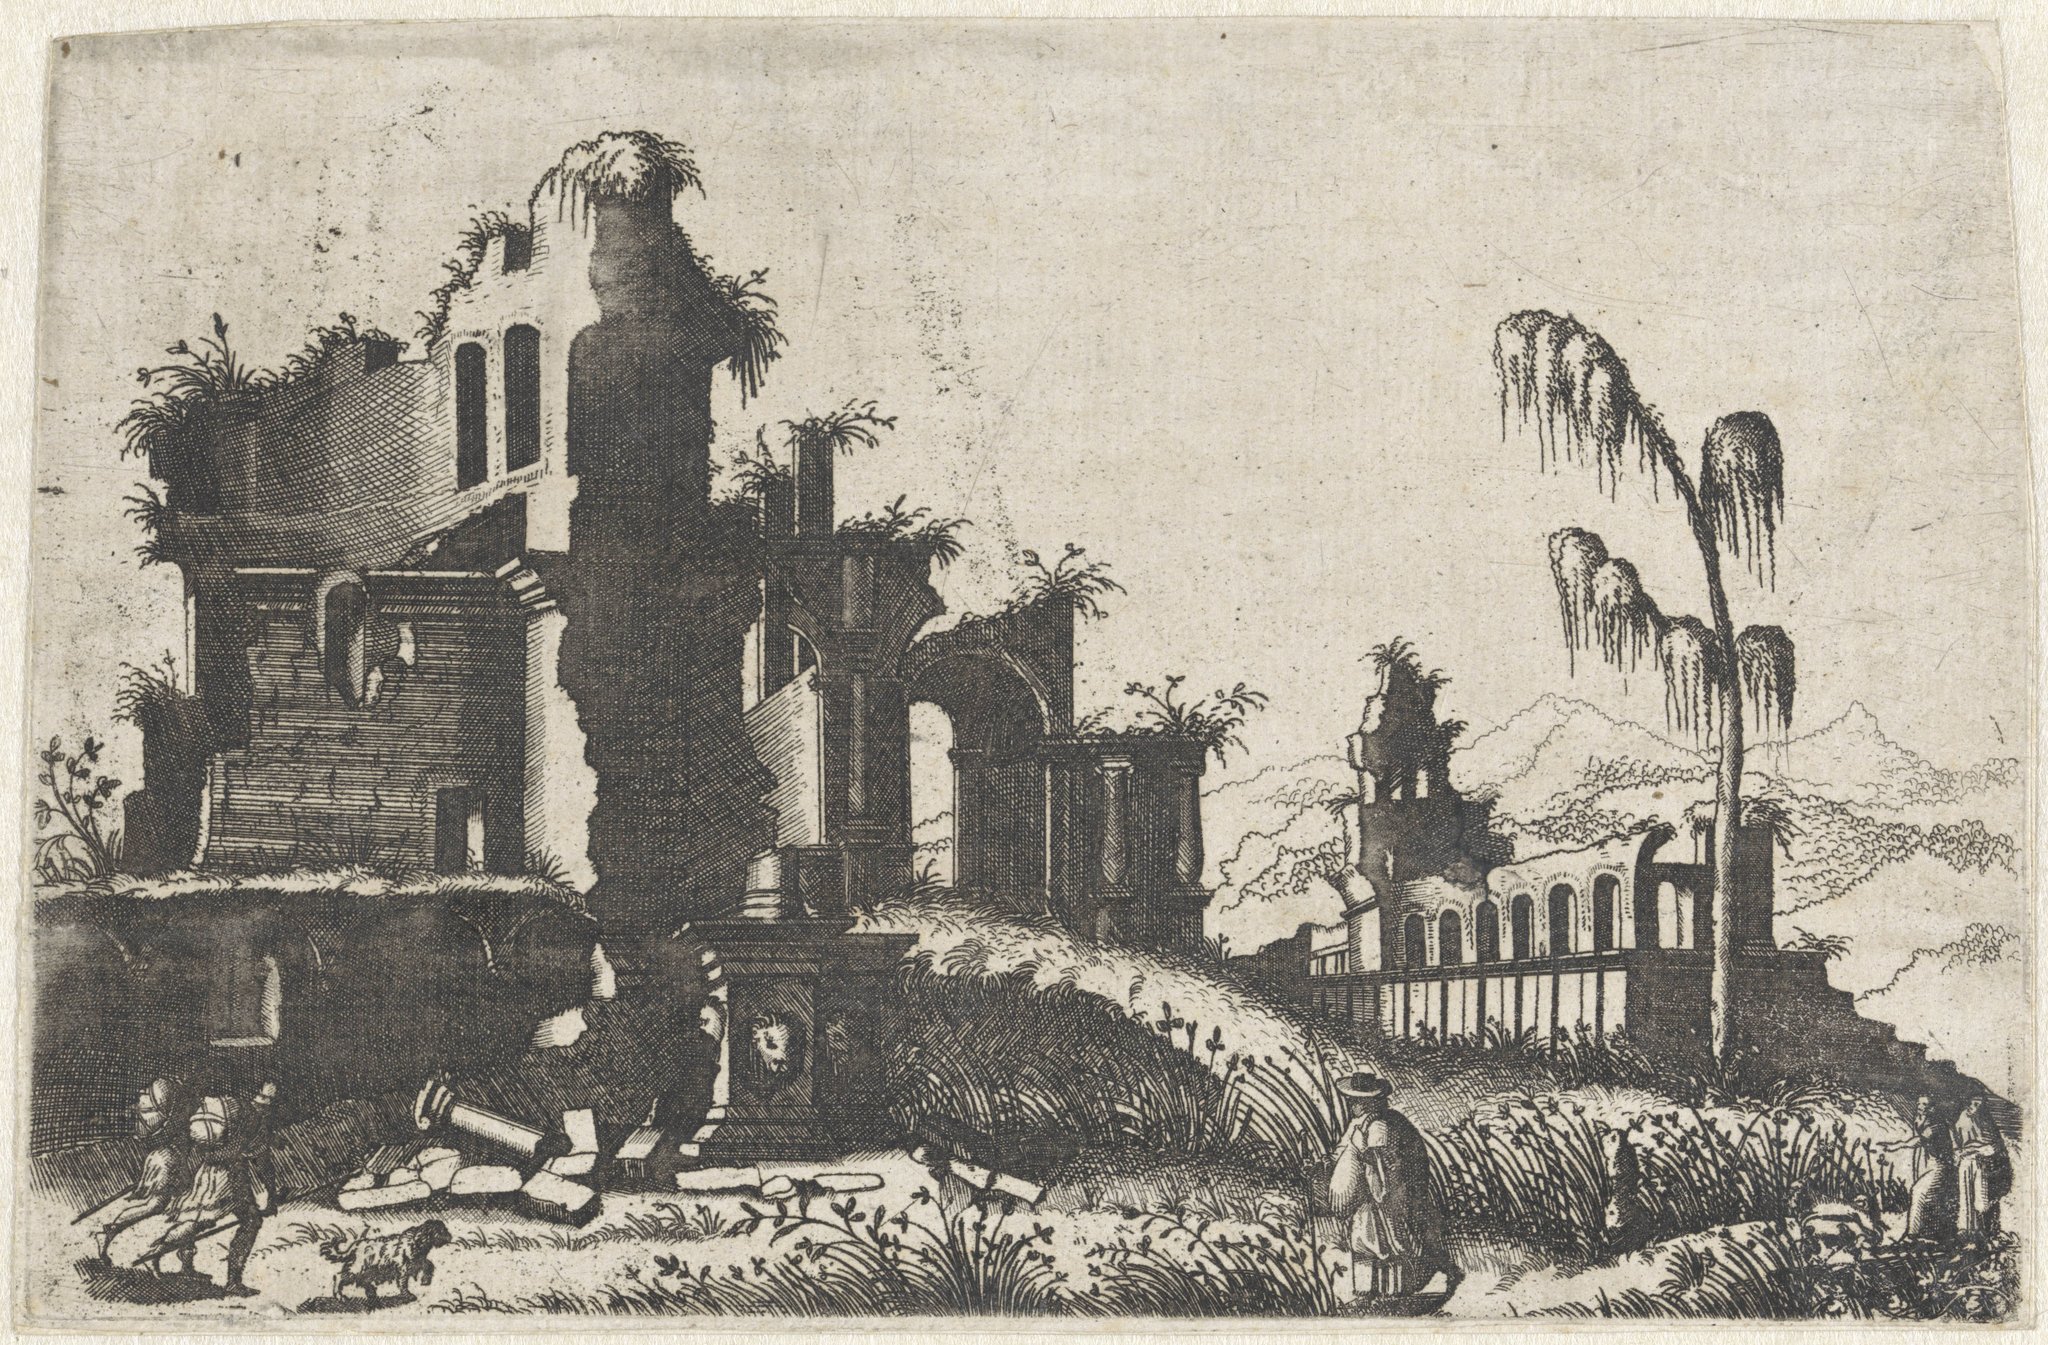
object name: print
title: Ruinarum variarum fabricarum delineationes pictoribus caeterisque id genus artificibus multum utiles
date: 1560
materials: paper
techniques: etching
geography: antwerp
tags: landscape with ruins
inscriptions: collector's mark: Lugt 2228, collector's mark: Lugt 2760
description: Begroeide klassieke ruïnes in een landschap. Links op de voorgrond twee reizigers met een hond.